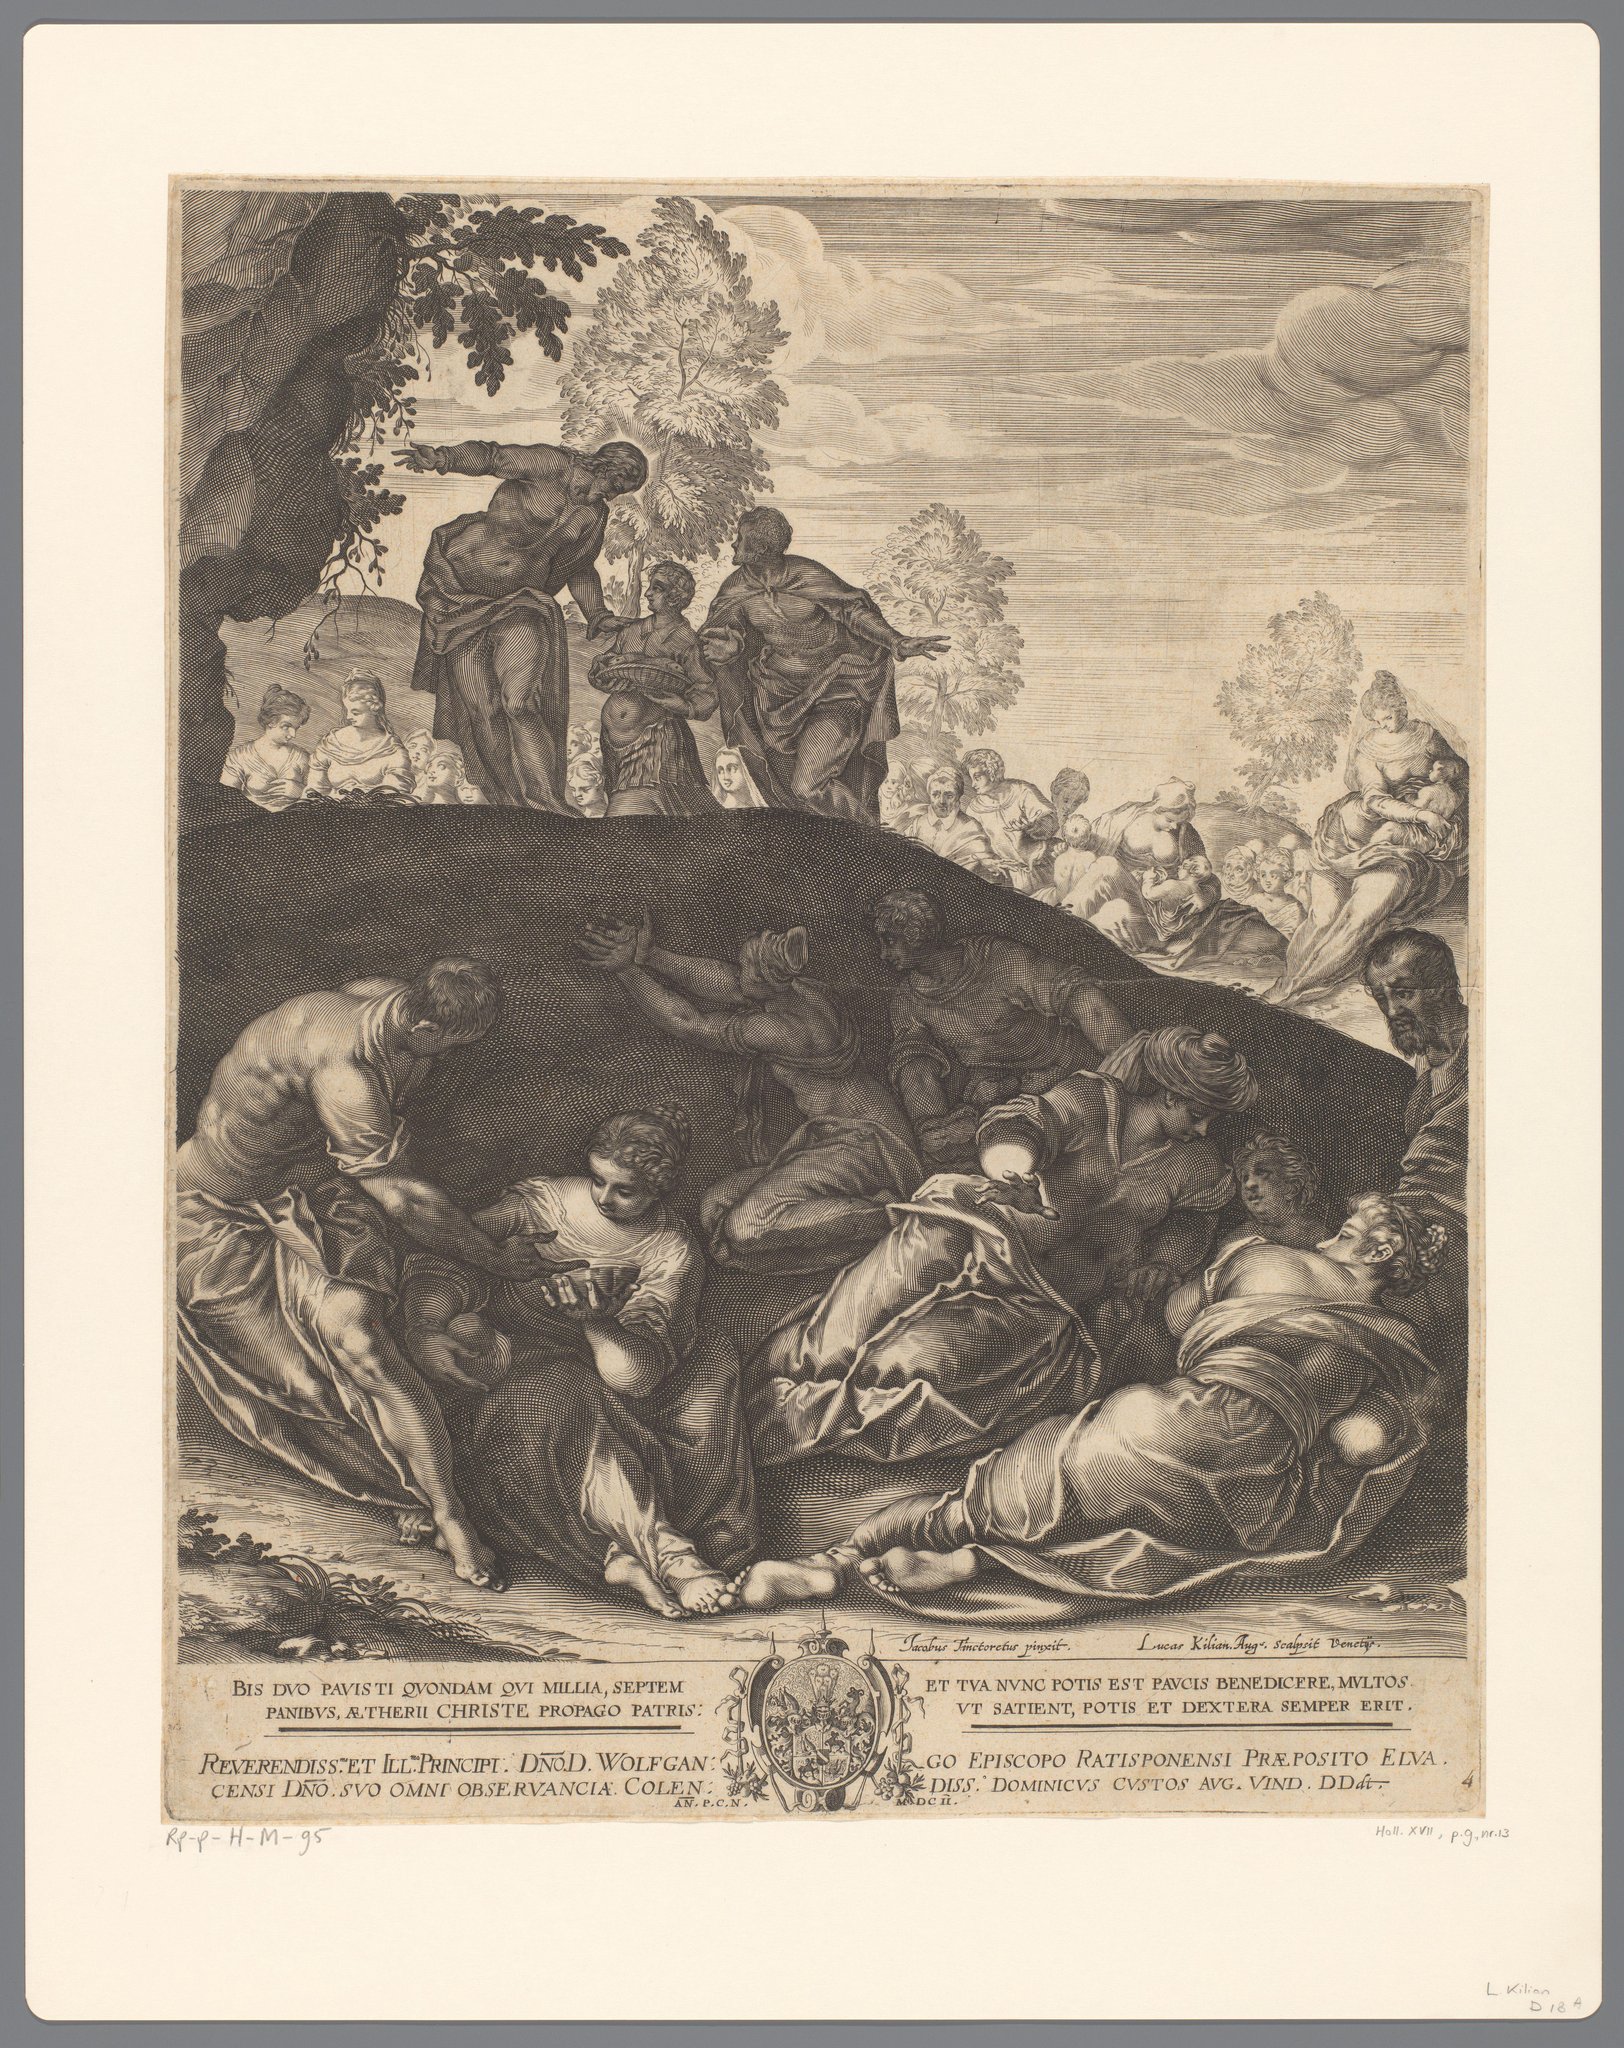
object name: print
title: Wonderbare spijziging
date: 1602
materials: paper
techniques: engraving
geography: augsburg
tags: christ blessing the bread and fish brought by a boy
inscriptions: collector's mark: Lugt 11, annotation: ‘4’, collector's mark: Lugt 10